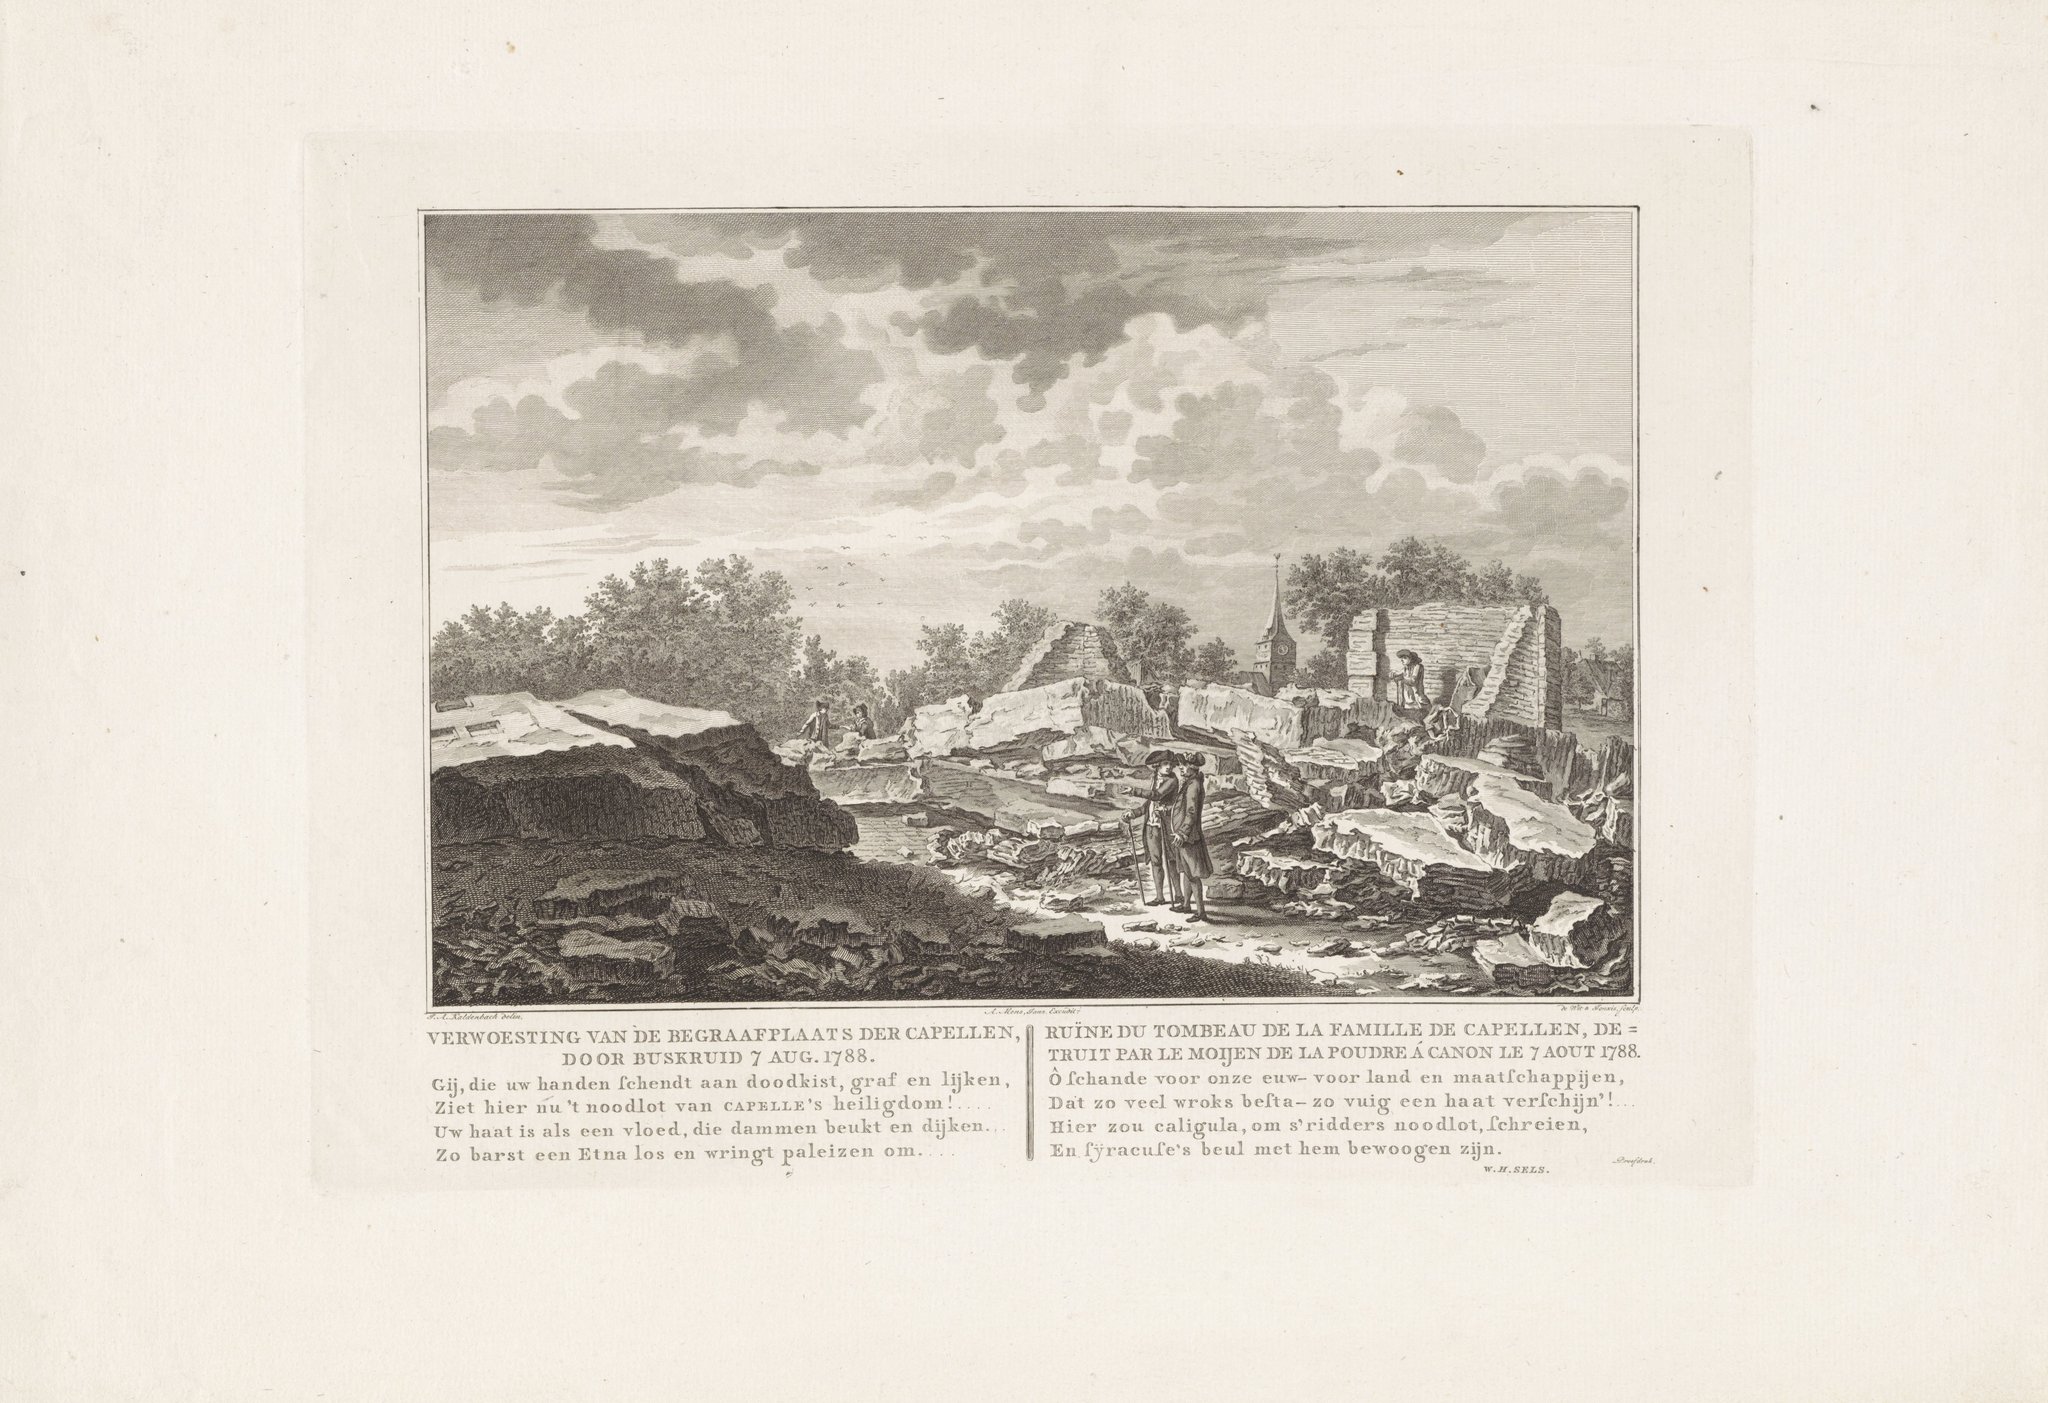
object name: print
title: Verwoesting van de begraafplaats der Capellen, door buskruid 7 aug. 1788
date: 1788-1790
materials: paper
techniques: engraving, etching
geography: amsterdam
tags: landscape with other man-made constructions not mentioned above, e.g.: graveyards, playgrounds, etc., gunpowder disaster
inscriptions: collector's mark: Lugt 2233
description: Landschap met verwoeste begraafplaats van familie Van der Capellen met op de voorgrond twee wandelaars. Op de achtergrond een kerktoren.